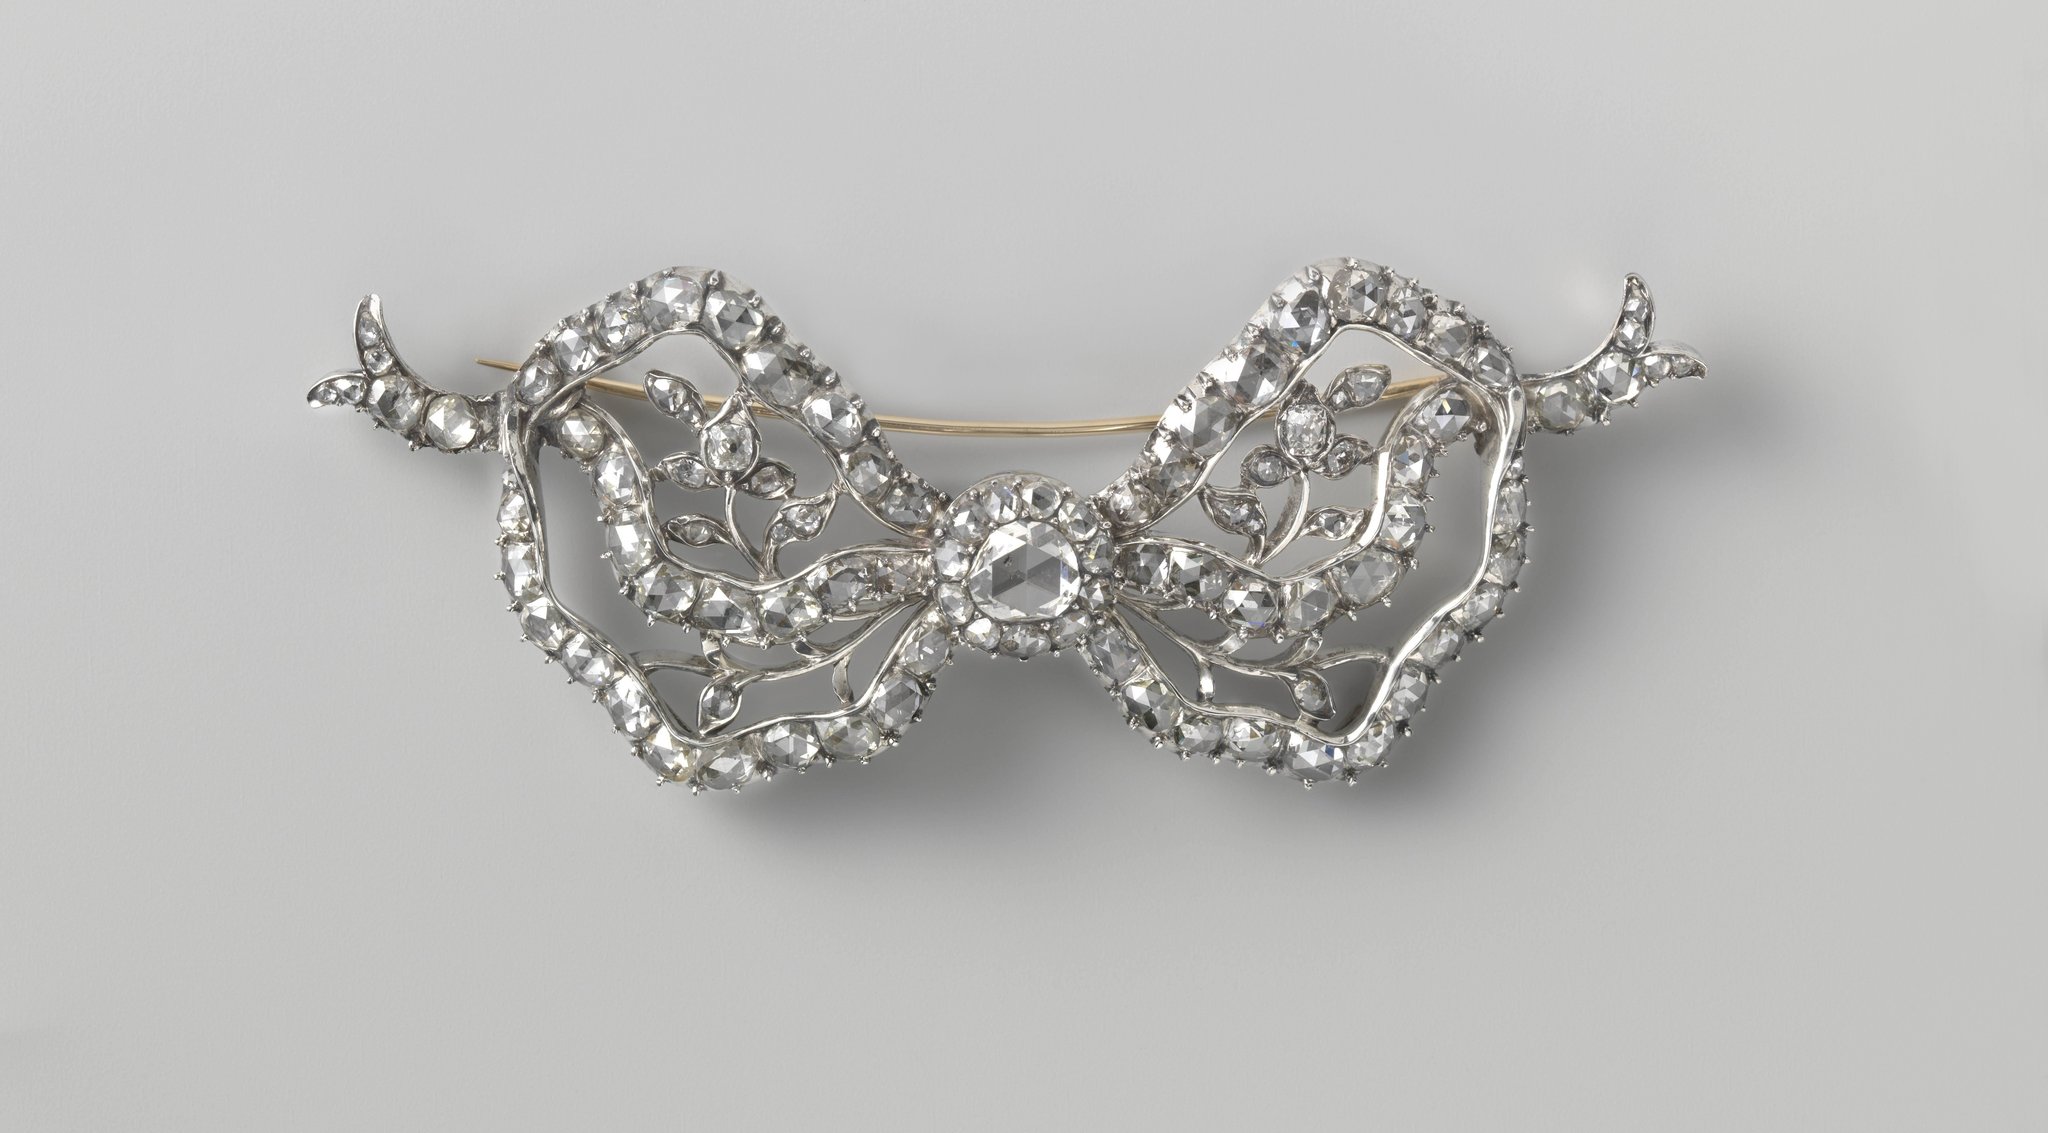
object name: brooch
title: Bow-shaped Brooch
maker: adrianus steen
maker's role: jeweler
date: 1784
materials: diamond, gold, silver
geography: amsterdam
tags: mozes en aäronkerk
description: While this diamond bow now serves as a brooch, its original function was different. The jeweller Adrianus Steen fashioned the bow in 1784 as part of a monstrance for the Catholic Mozes en Aäronkerk in Amsterdam. The bow is set with rose-cut diamonds, only the top sides of which are faceted.